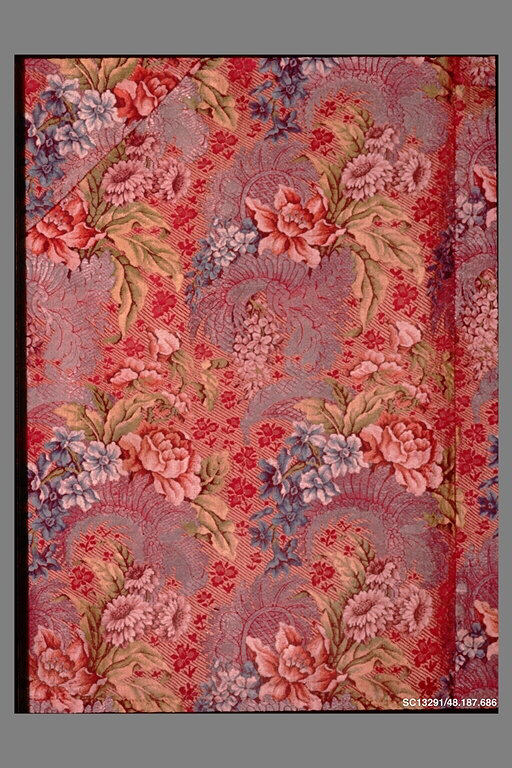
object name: piece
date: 1730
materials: metal thread, silk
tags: flowers,leaves